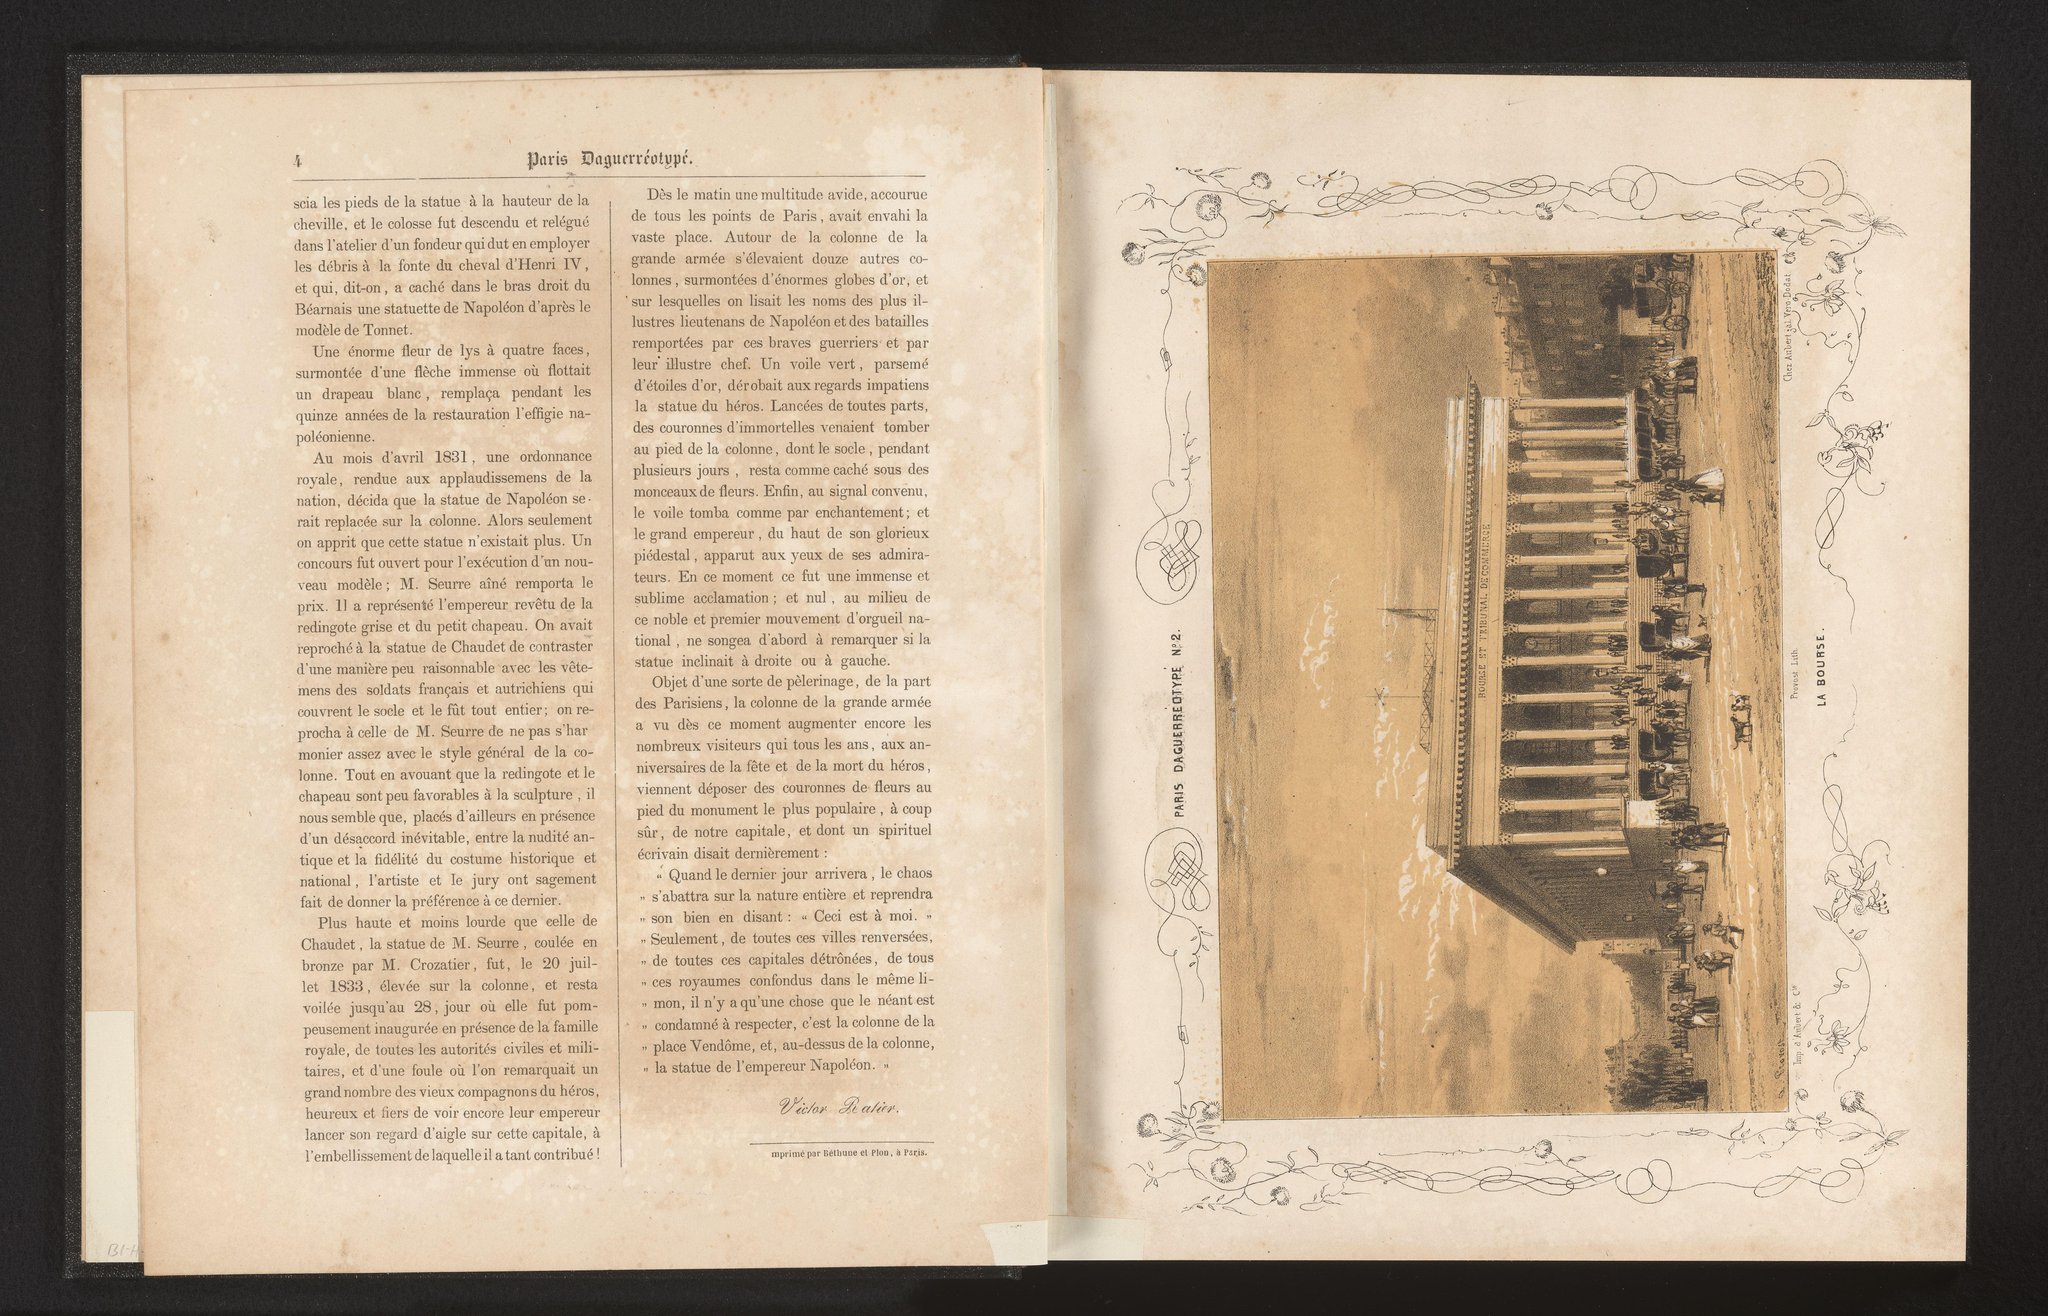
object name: page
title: Gezicht op het Palais Brongniart in Parijs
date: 1839-1840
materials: paper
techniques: tone lithography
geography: paris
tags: palace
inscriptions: inscription: ‘PARIS DAGUERRÉOTYPÉ No. 2.’